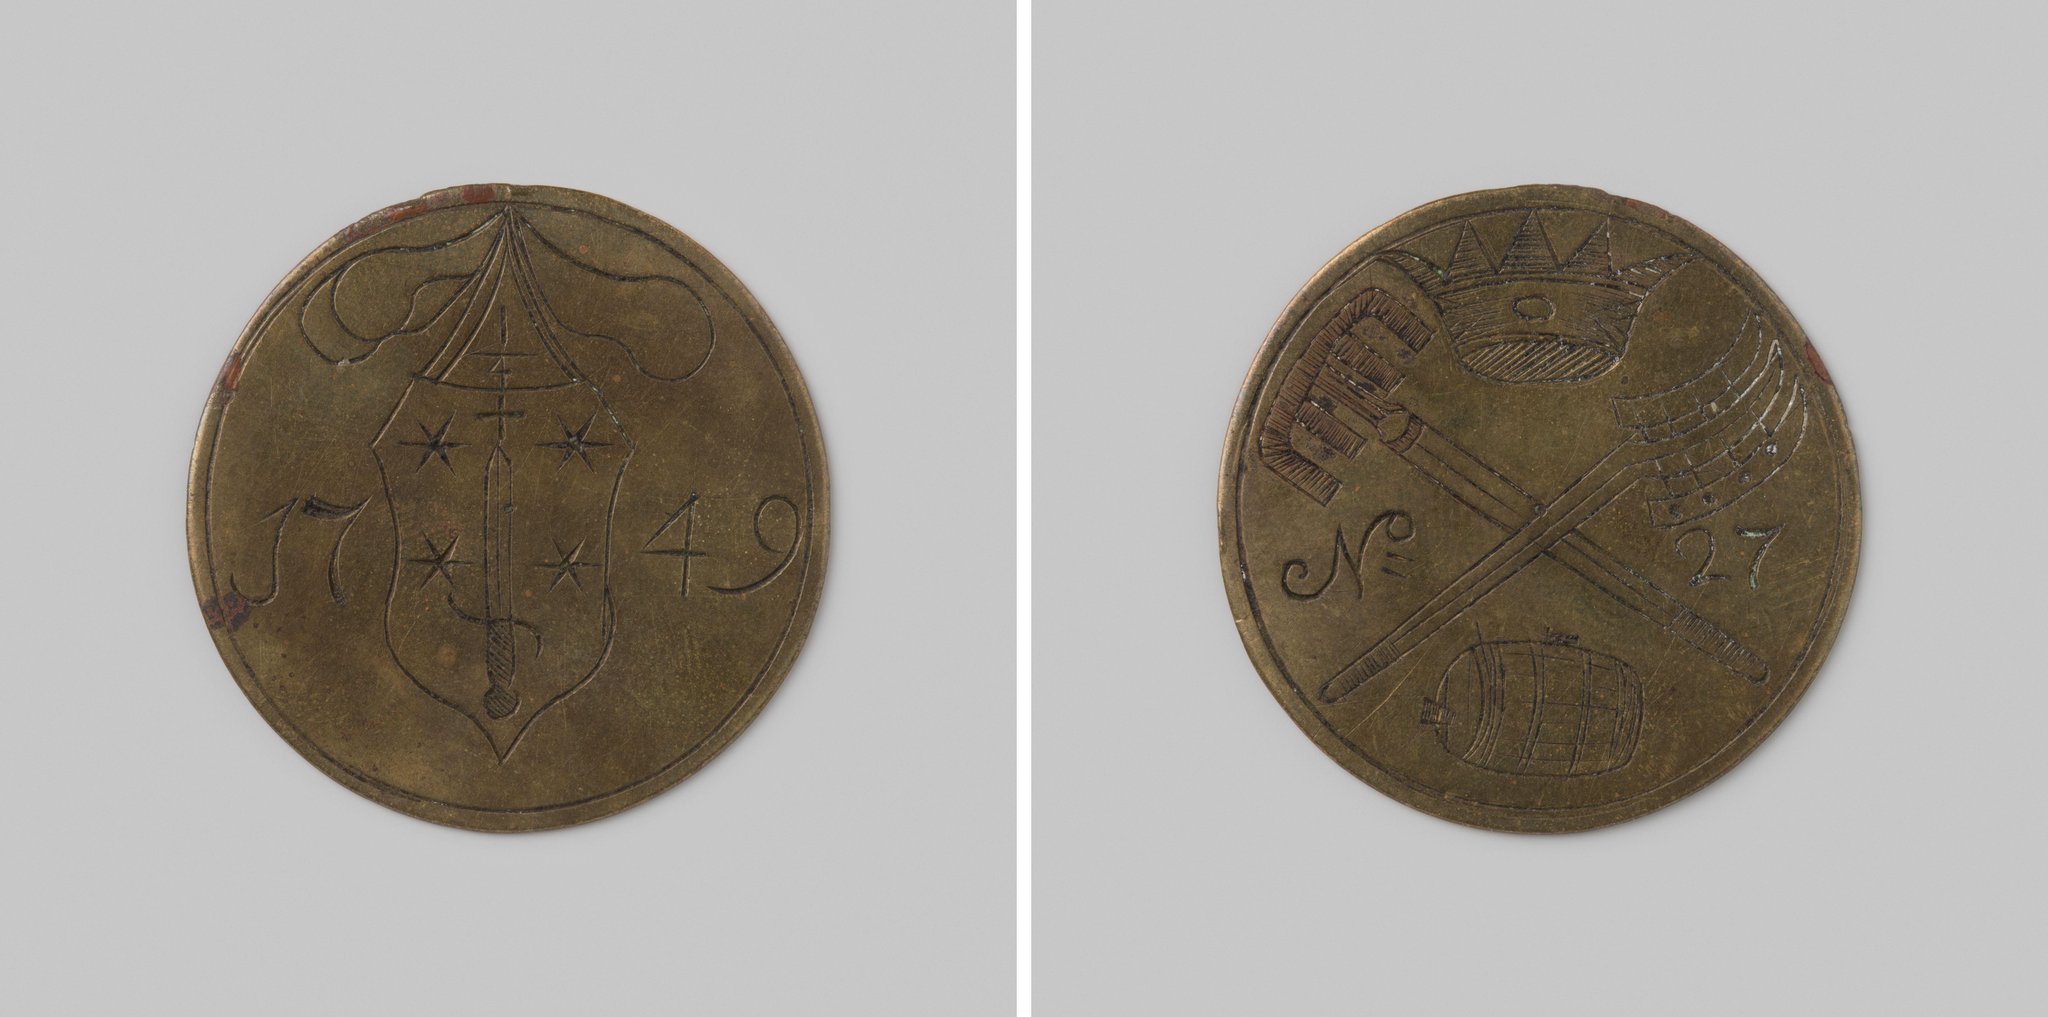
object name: history medal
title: Presentiepenning van het Sint Maarten- of brouwersgilde te Haarlem 1749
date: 1749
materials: brass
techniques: engraving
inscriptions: inscription: ‘N° - 27’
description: Rond messing plaatje gegraveerd op de voorzijde het wapenschild van Haarlem tussen 17 en 49, bovenaan 1/4, op de keerzijde een kroon, een gekruiste mouthaak en vork en een bierton, genummerd 27